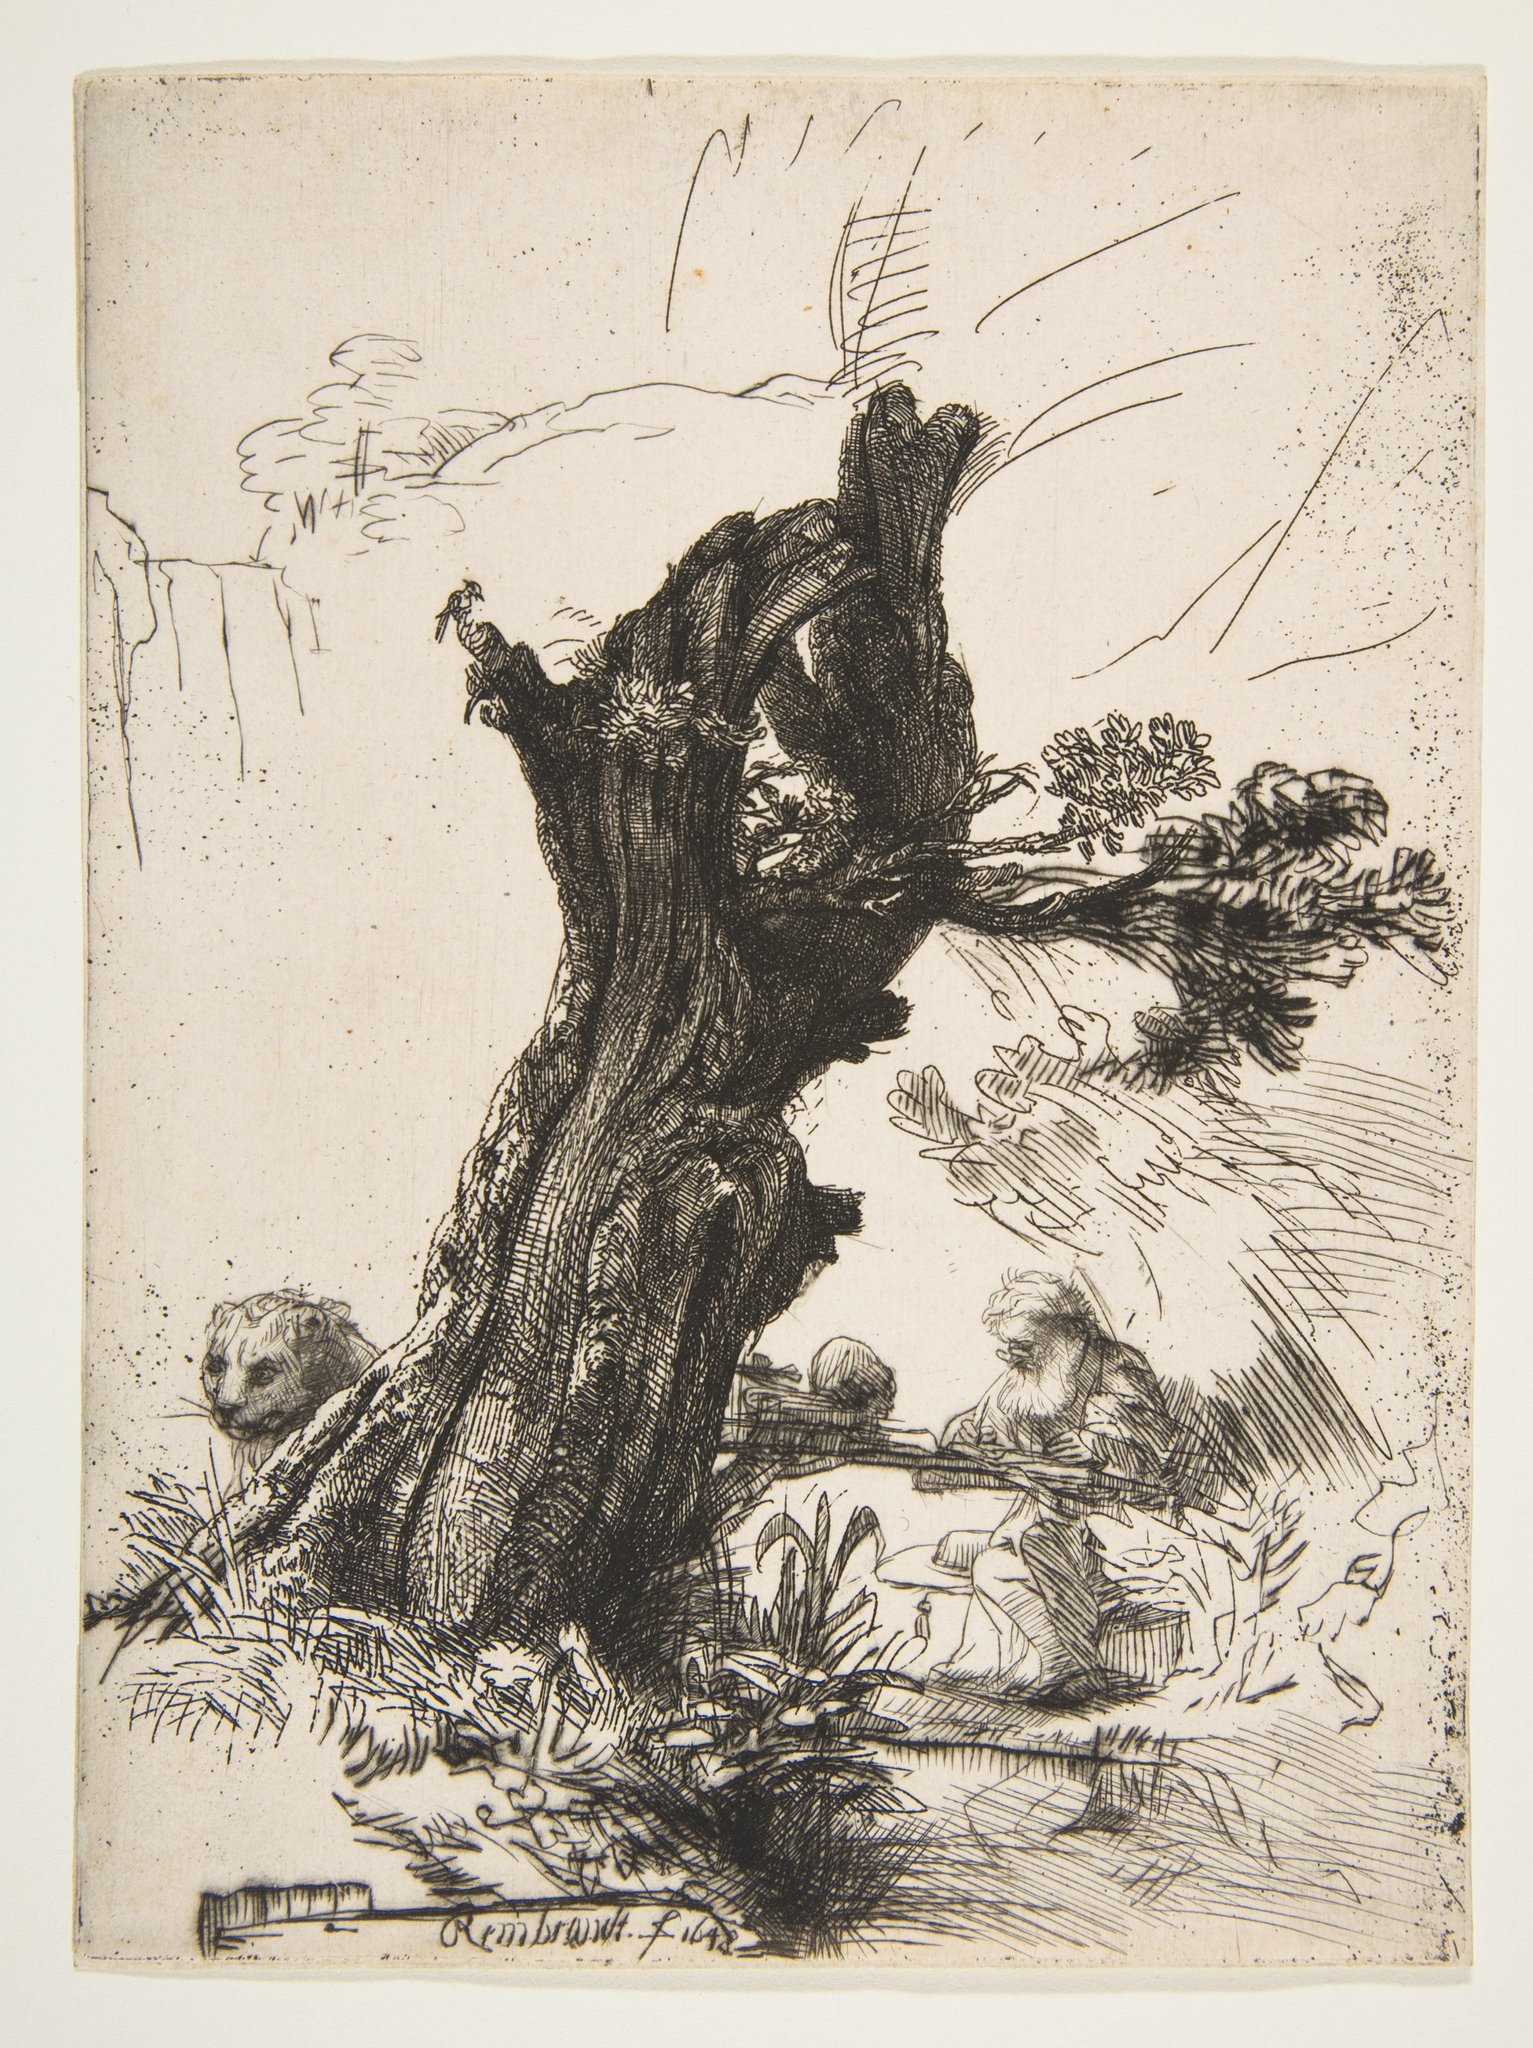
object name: print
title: St. Jerome beside a Pollard Willow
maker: rembrandt van rijn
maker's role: artist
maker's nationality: dutch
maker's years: 1606-1669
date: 1648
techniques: drypoint, etching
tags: animals,trees,saint jerome